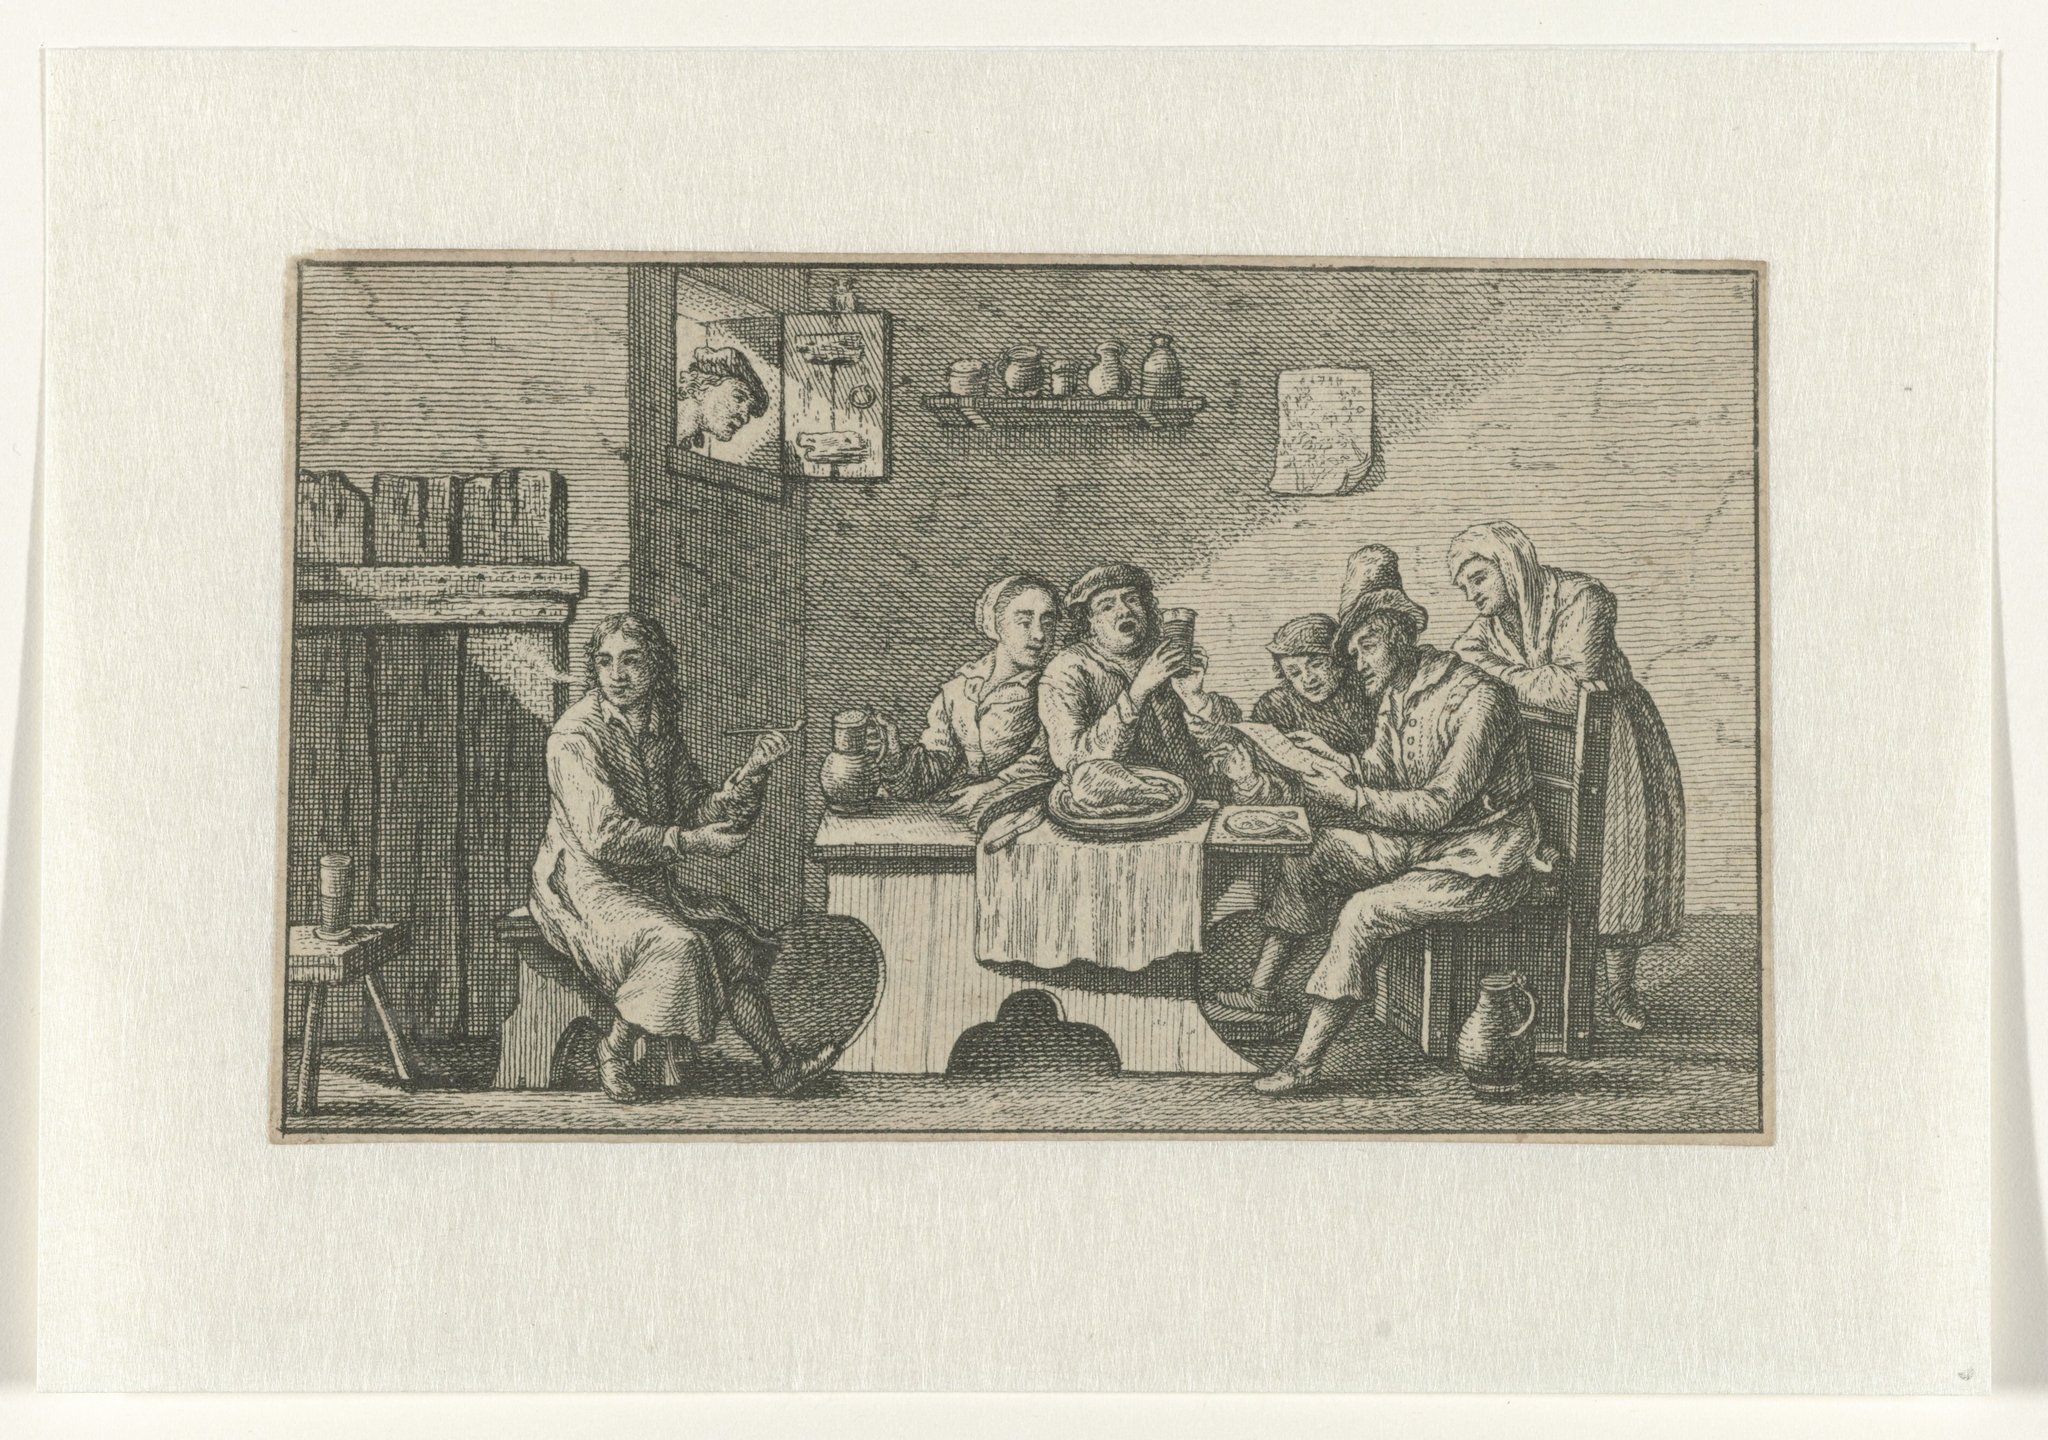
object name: print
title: Zes lieden in een interieur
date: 1690-1730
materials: paper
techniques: etching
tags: inn, coffee-house, public house, etc., pipe ~ tobacco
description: Na de overname van de firma Niemeyer door British American Tabacco Group besloot deze de collectie van het Niemeyer Tabaksmuseum af te stoten. De beheerder van de collectie, het Noordelijk Scheepvaartmuseum, organiseerde in januari 2011 open dagen voor musea waar deze hun voorkeuren voor collectieonderdelen kenbaar konden maken. De objecten zijn getaxeerd door medewerkers van Christie's en vervolgens ter overname aangeboden aan de belangstellende musea. Het Rijksprentenkabinet koos 46 prenten uit de collectie tegen door de medewerkers van Christie's vastgestelde waarde. [H. Leeflang, 2011-06-09]